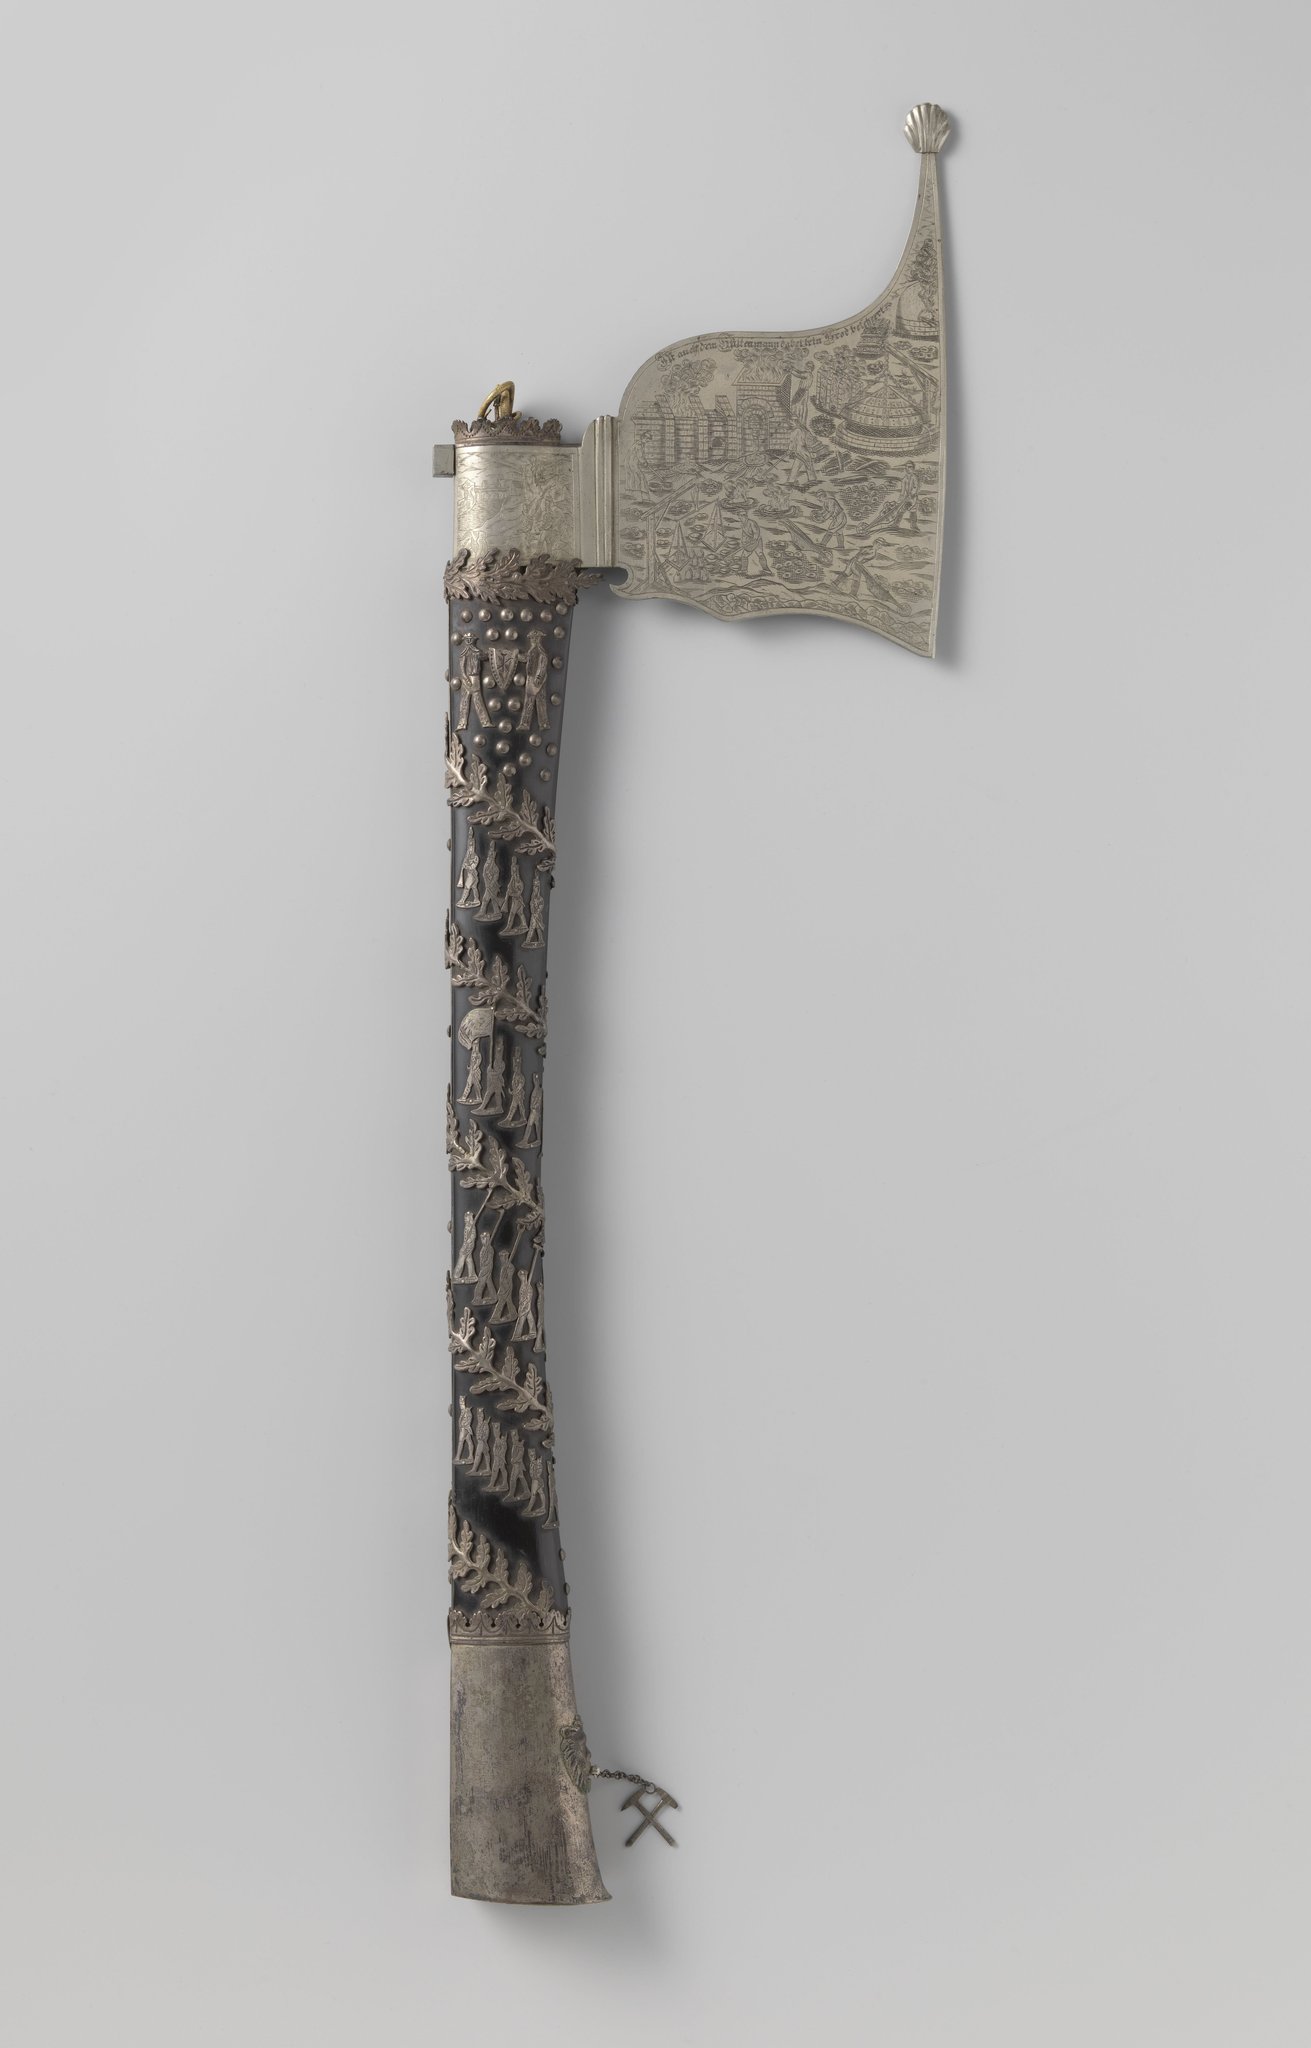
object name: ax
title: Bijl met voorstelling van het mijnwezen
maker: a. muhlhausen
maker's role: silversmith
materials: silver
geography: freiberg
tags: the hague, berlin, william i of the netherlands, mining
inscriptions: inscription: ‘Solang der Bergmann sich mit seinem Schägel nährt, ist auch dem Hüttenmann dabei sein Brot bescheert’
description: Zilveren bijl versierd met gegraveerde voorstelling van het mijnwezen met omschrift: 'Solang der Bergmann sich mit seinem Schägel nährt, ist auch dem Hüttenmann dabei sein Brot bescheert'. Op het handvat verschillende ertsen. Rondom het handvat een slinger van lauwerbladen en een optocht van mijnwerkers. Door de maker A. Muhlhausen aan koning Willem I ten geschenke gegeven.